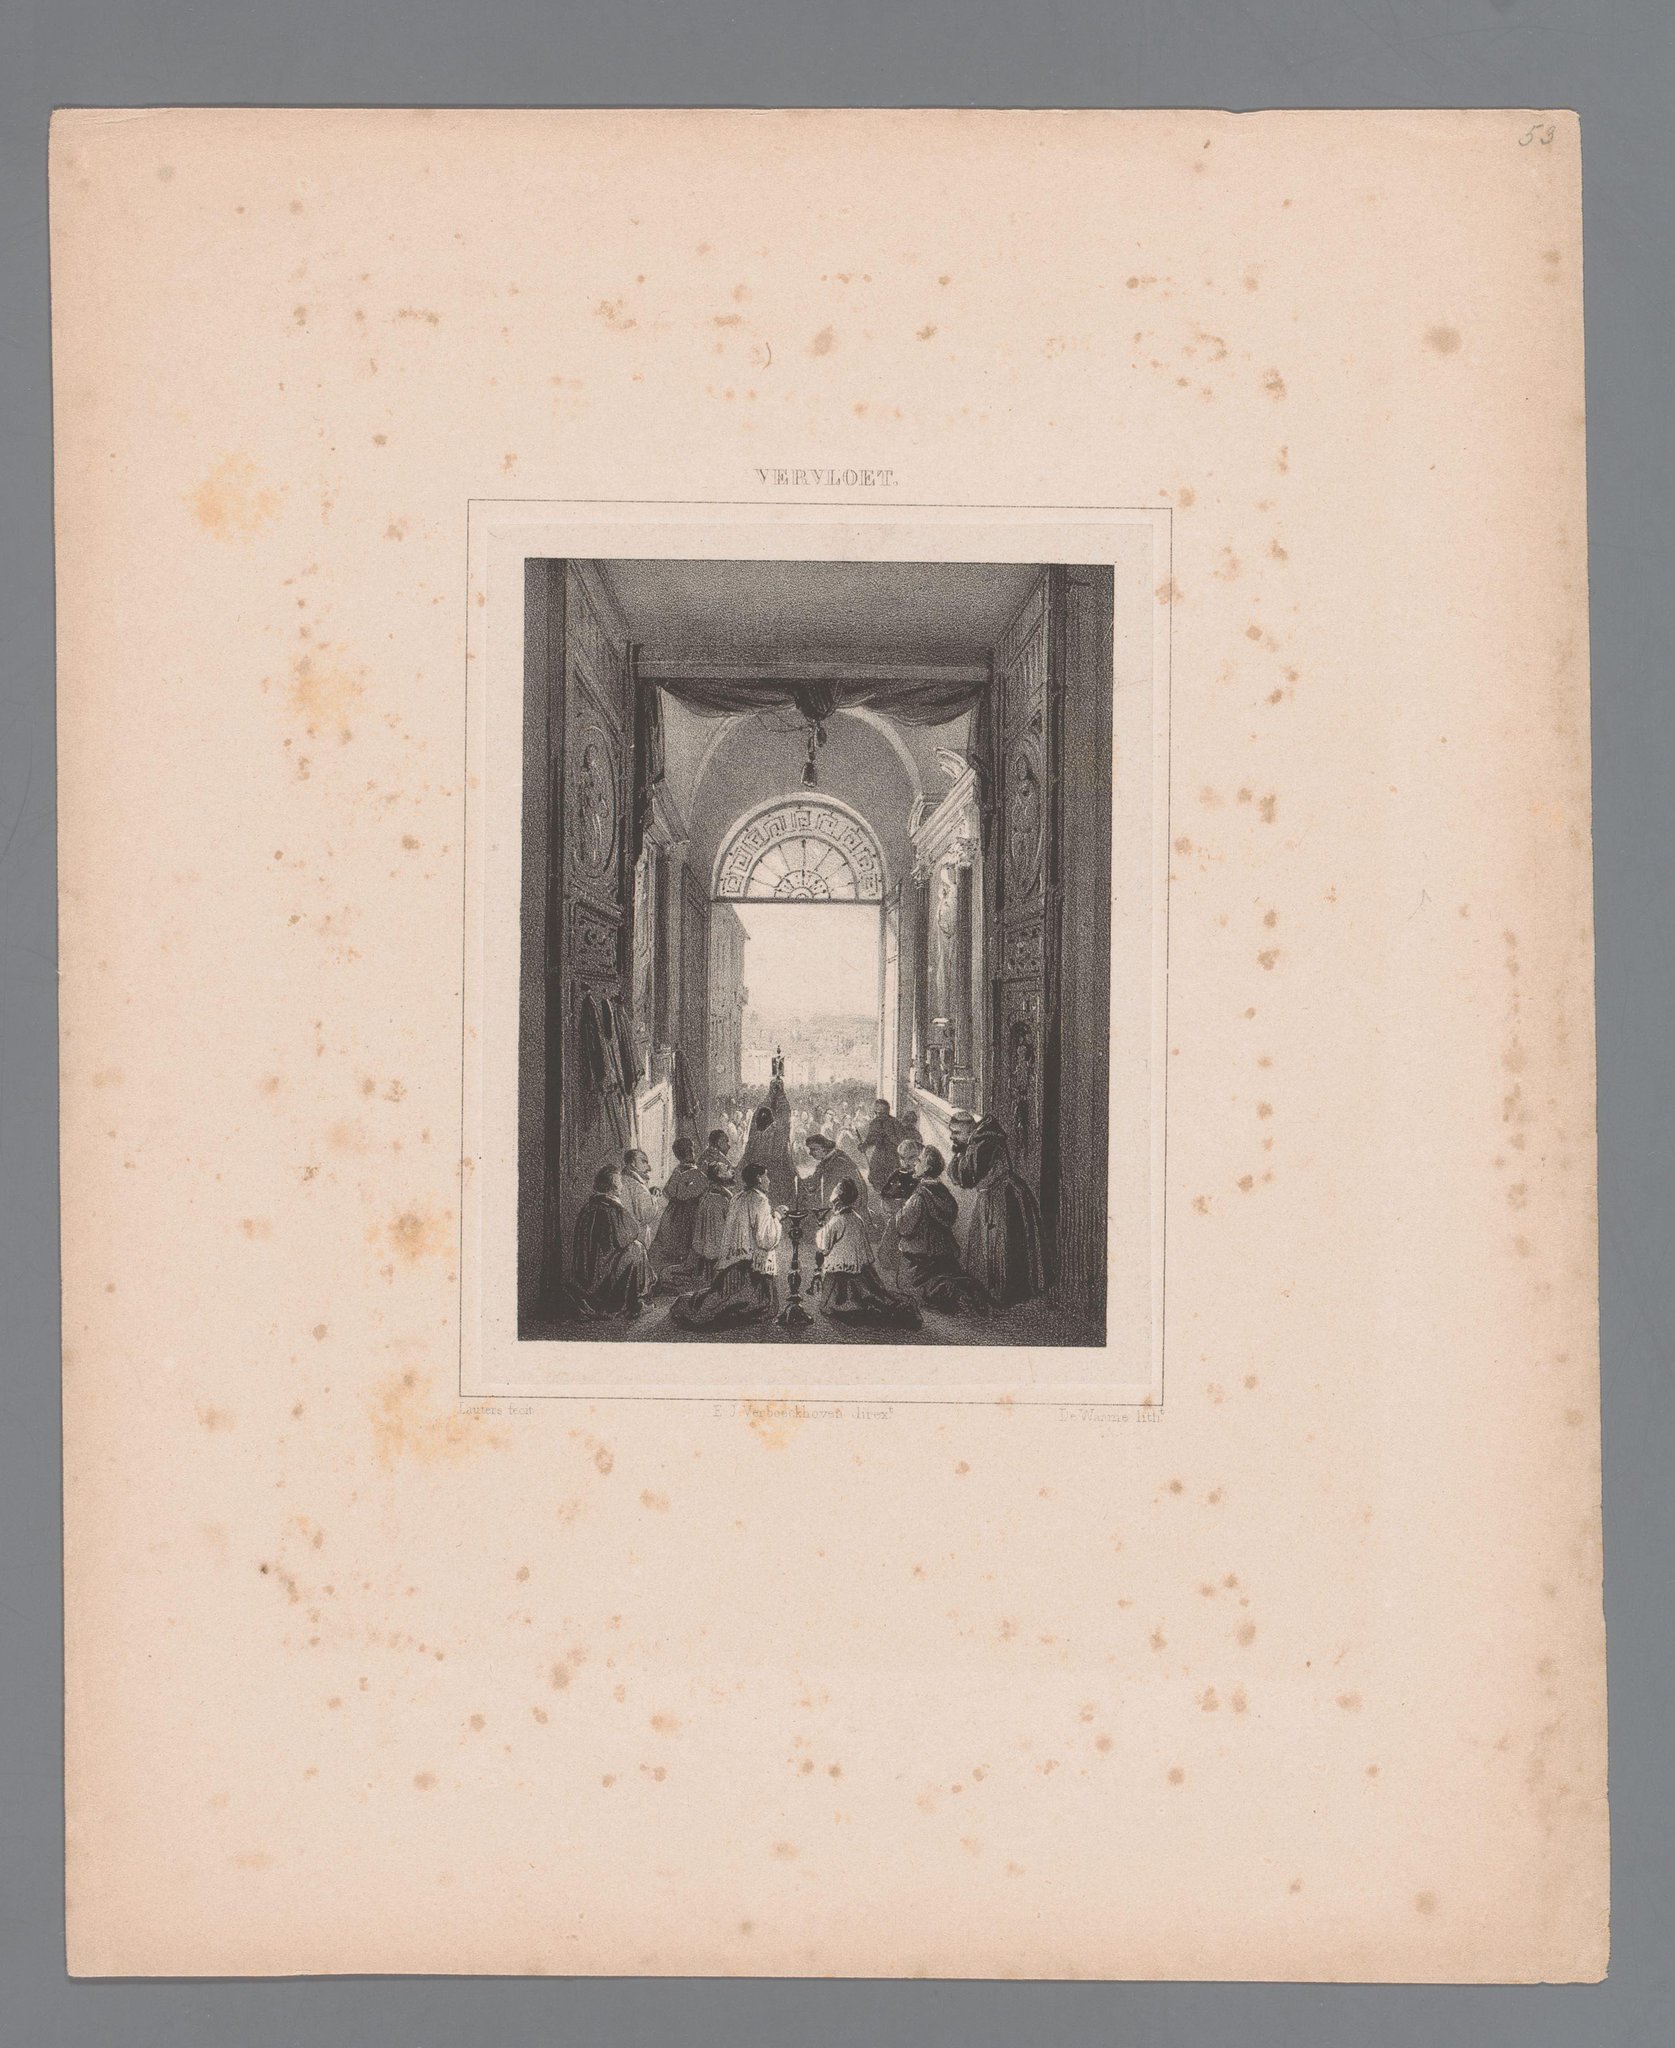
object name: print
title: Kerkdienst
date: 1829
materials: paper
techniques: lithograph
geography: brussels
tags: holy mass (divine service, especially of roman catholic church)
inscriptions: collector's mark: Lugt 2233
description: Prent verschenen in: Verboeckhoven, Eugène. Album lithographié par Paul Lauters d'après les dessins des principaux peintres du Royaume des Pays-Bas. Brussel: Antoine Dewasme-Pletinckx, 1829.